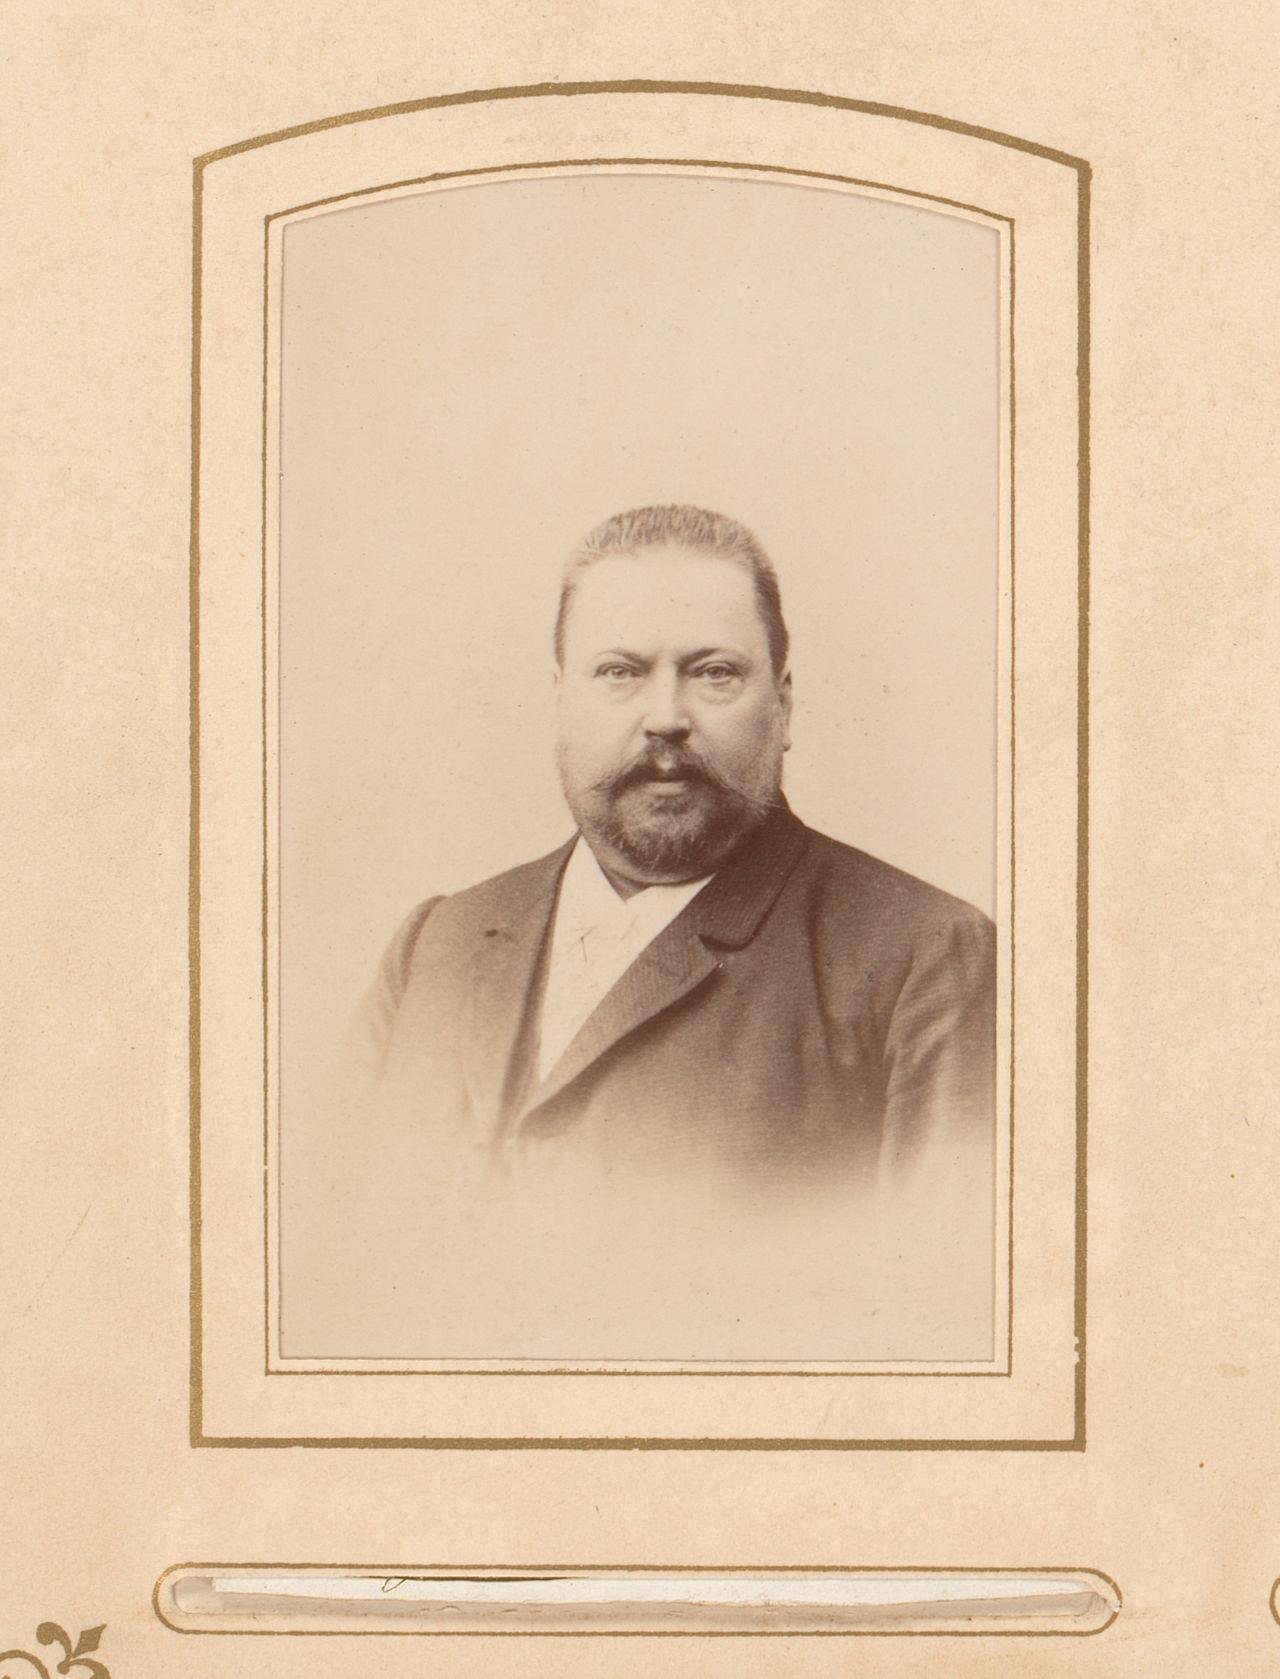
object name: photograph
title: Portret van een man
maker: louis oskar grienwaldt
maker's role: fotograaf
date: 1890-1900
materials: cardboard, photographic support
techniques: albumen print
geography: bremen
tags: historical persons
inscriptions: inscription: ‘L.O.GRIENWALDT/ Photograph. Jnstitut/ BREMEN/ WALL 86./ (...)/ Prämiirt:/ Hannover, Melbourne,/ Hamburg, Nürnberg, Utrecht, Eisenach,/ Bremen 1890 Silberne Medaille.’